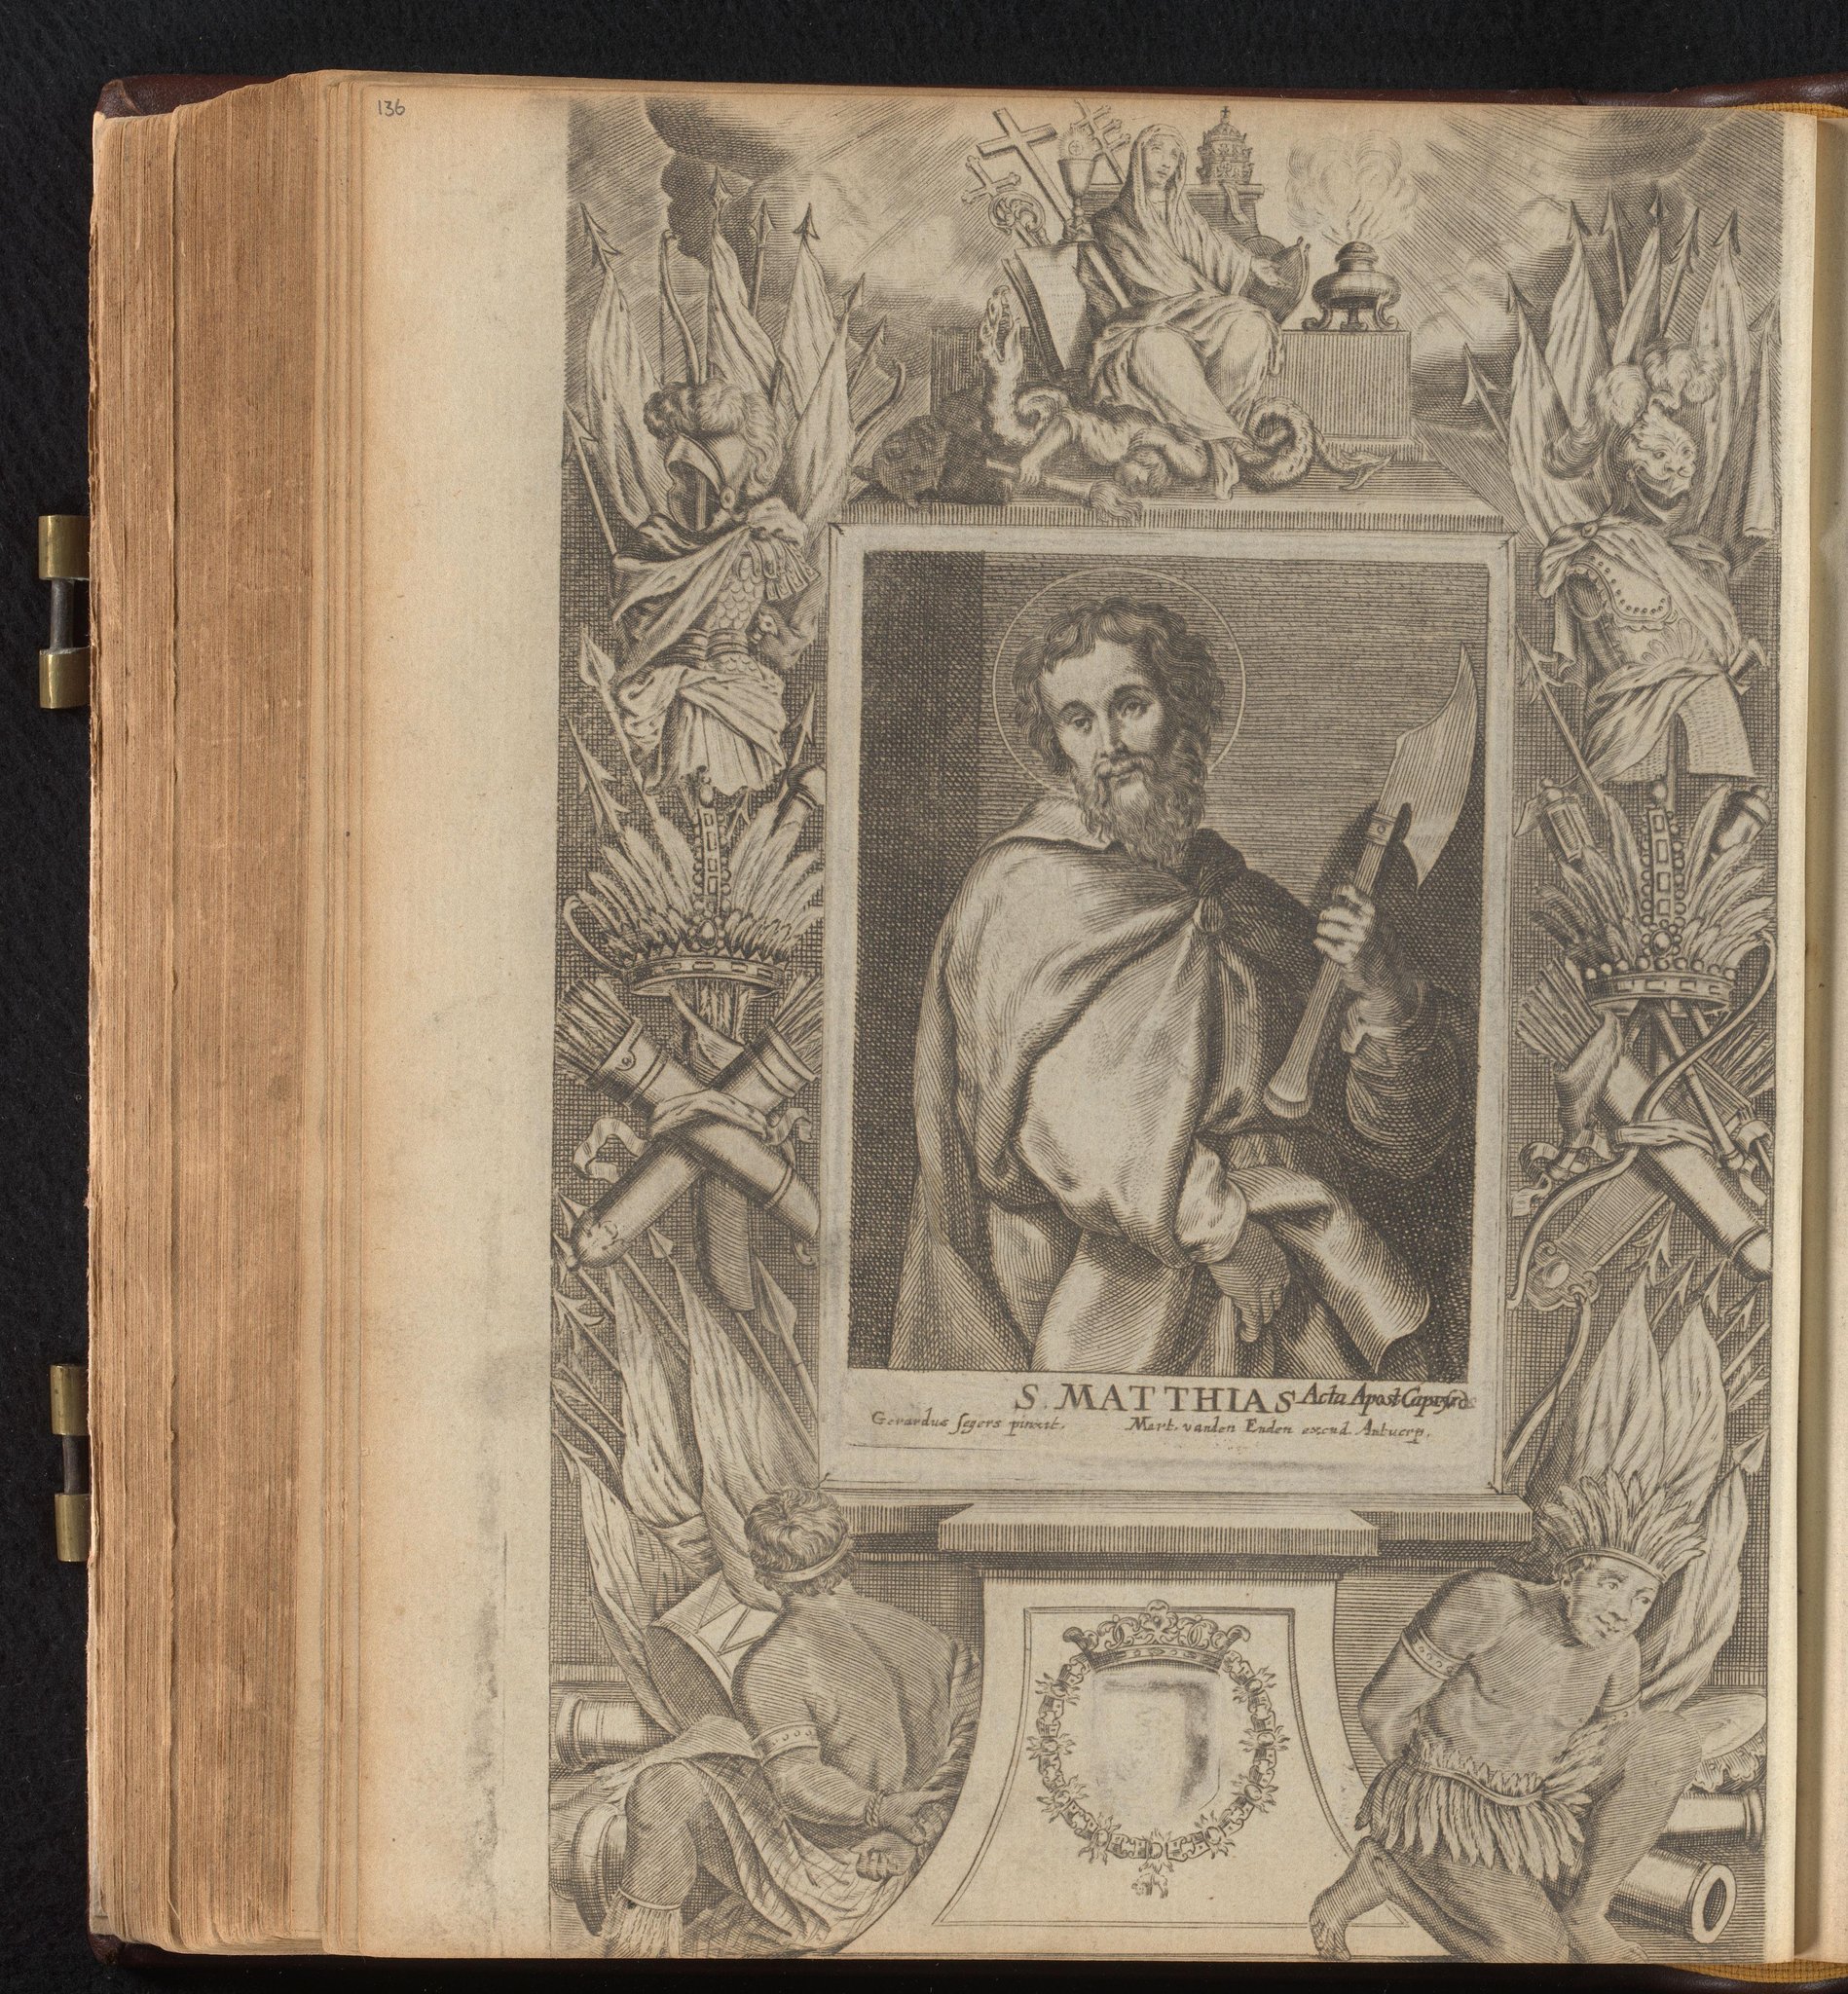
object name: print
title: Heilige Mattias met bijl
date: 1783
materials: paper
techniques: engraving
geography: southern netherlands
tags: fides (faith) as roman personification, archer's weapons: bow and arrow, armour, the apostle and martyr matthias; possible attributes: axe, book, cross, halberd, scroll, sword, indigenous peoples of north america, armorial bearing, heraldry, smoking pot as symbol of 'vanitas'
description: Prent maakt deel uit van een prentbijbel.